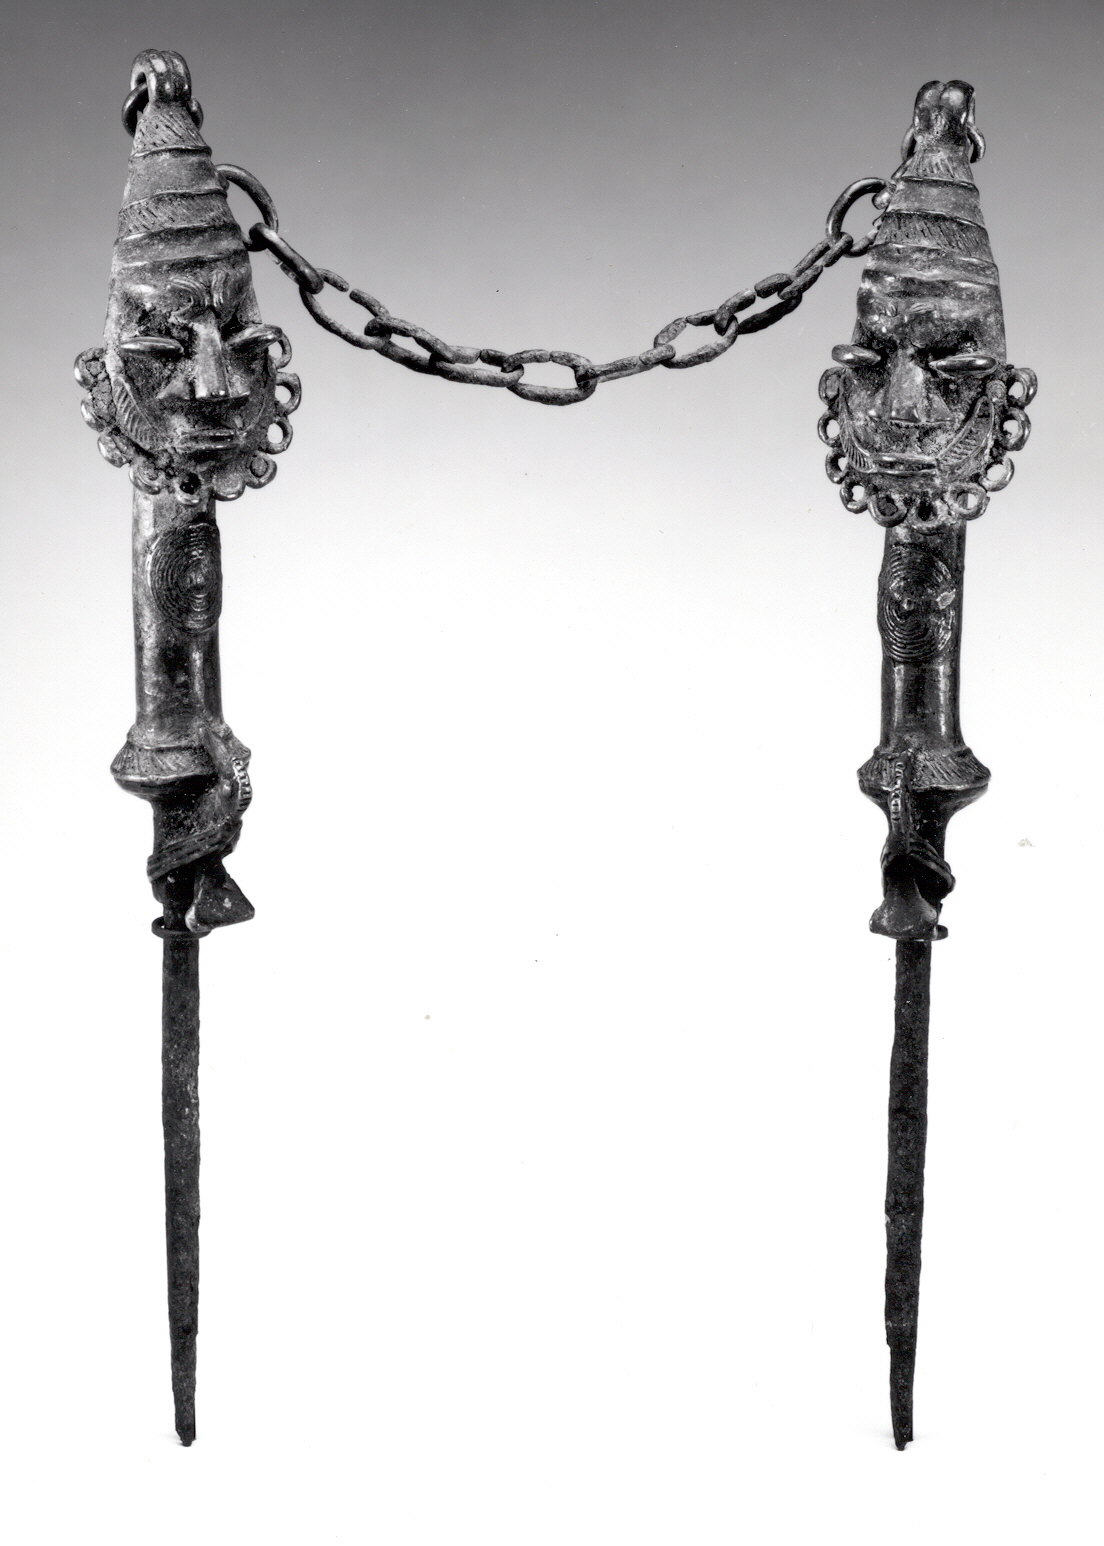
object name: staff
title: Staffs: Couple (Edan Ogboni)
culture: yoruba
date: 1801-1900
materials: brass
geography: nigeria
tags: couples